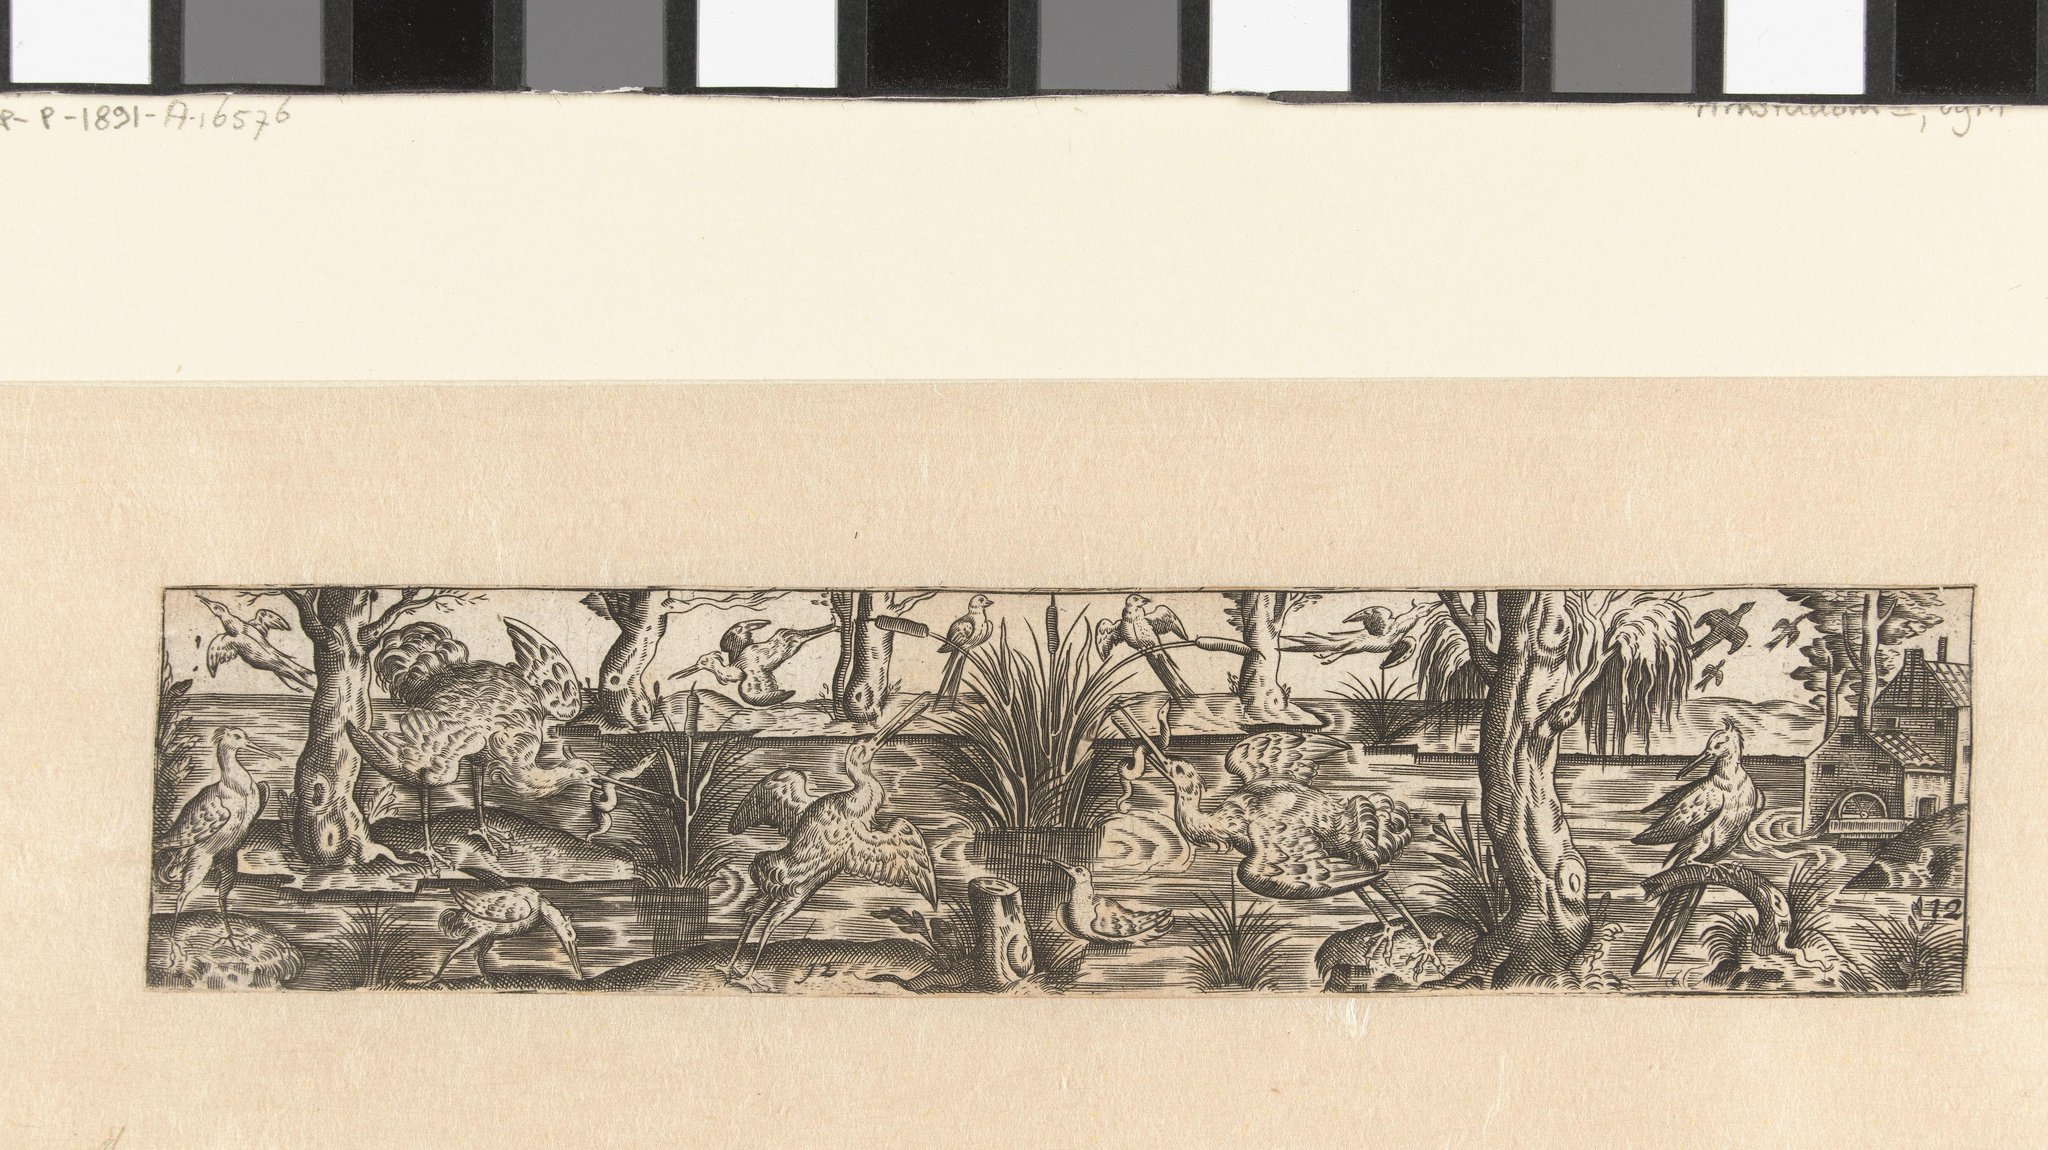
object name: ornament print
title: Fries met dertien vogels bij een water omringd door bomen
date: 1631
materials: paper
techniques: engraving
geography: netherlands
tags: birds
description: Rechts staat een watermolen. Blad 12 uit serie van 12 genummerde bladen.